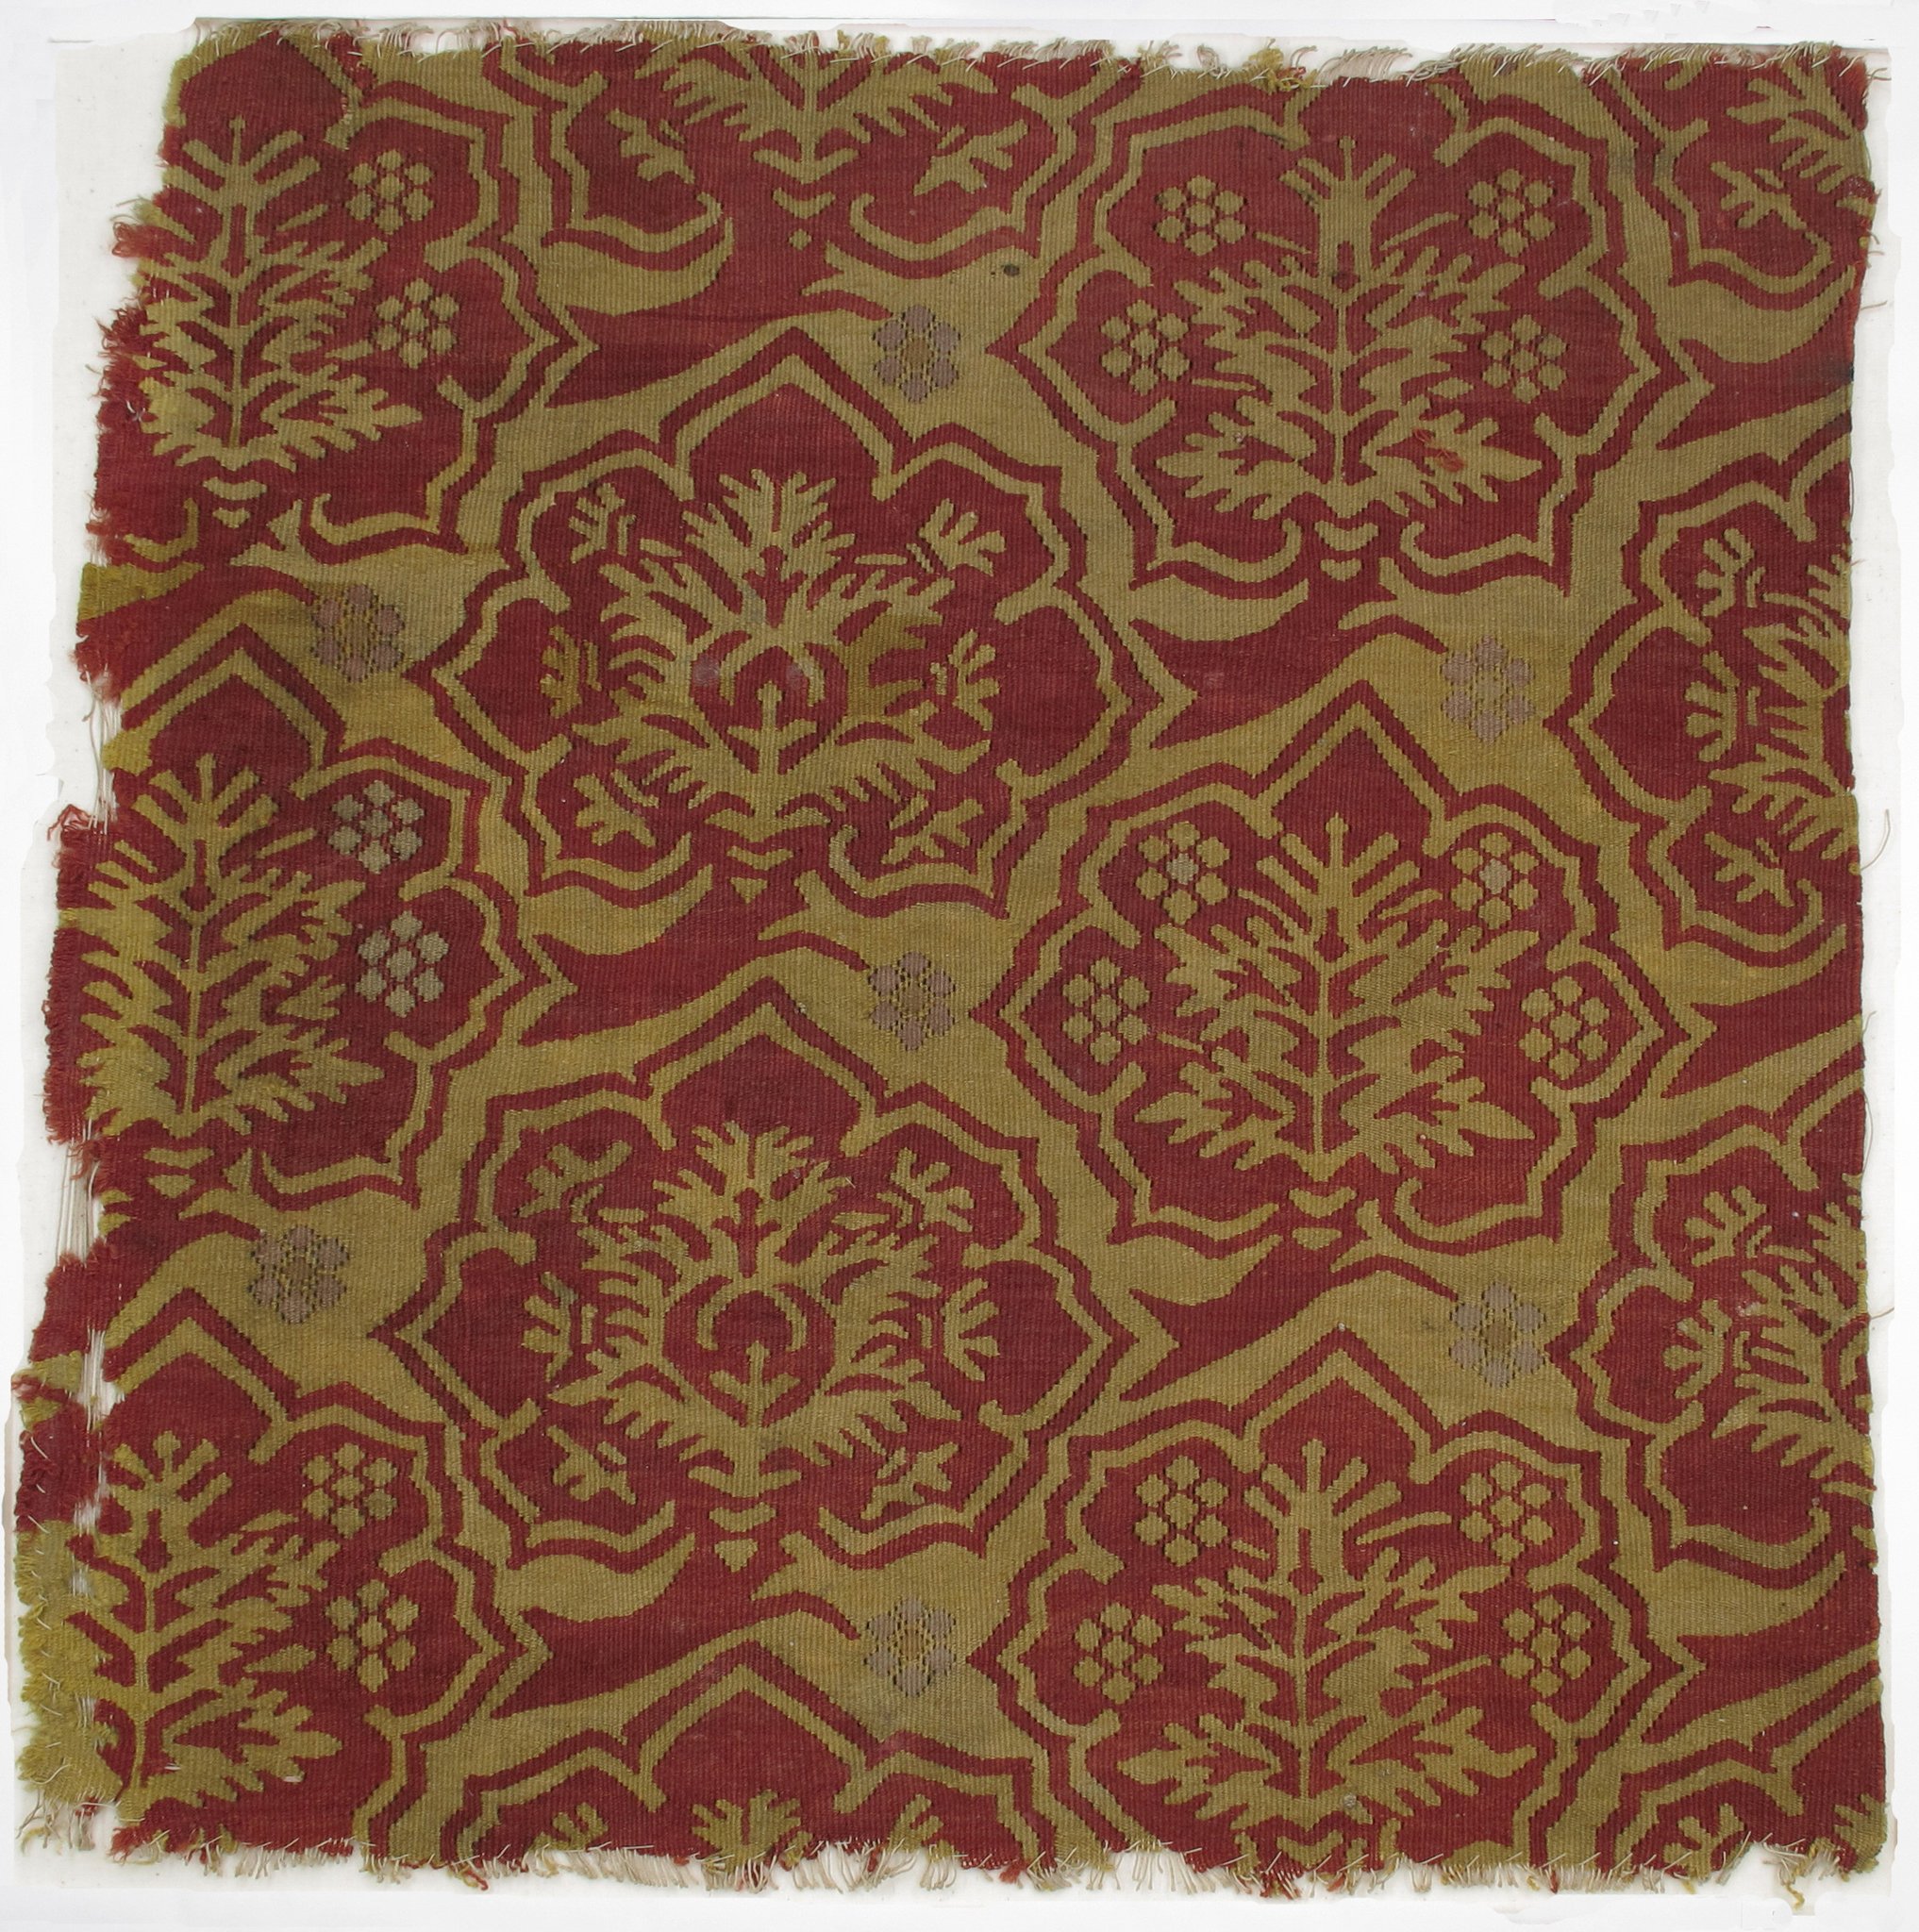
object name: fragment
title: Fragment with a Simulated Silk Textile Pattern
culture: upper rhenish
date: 1450-1550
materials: linen, wool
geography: nuremberg/strasbourg